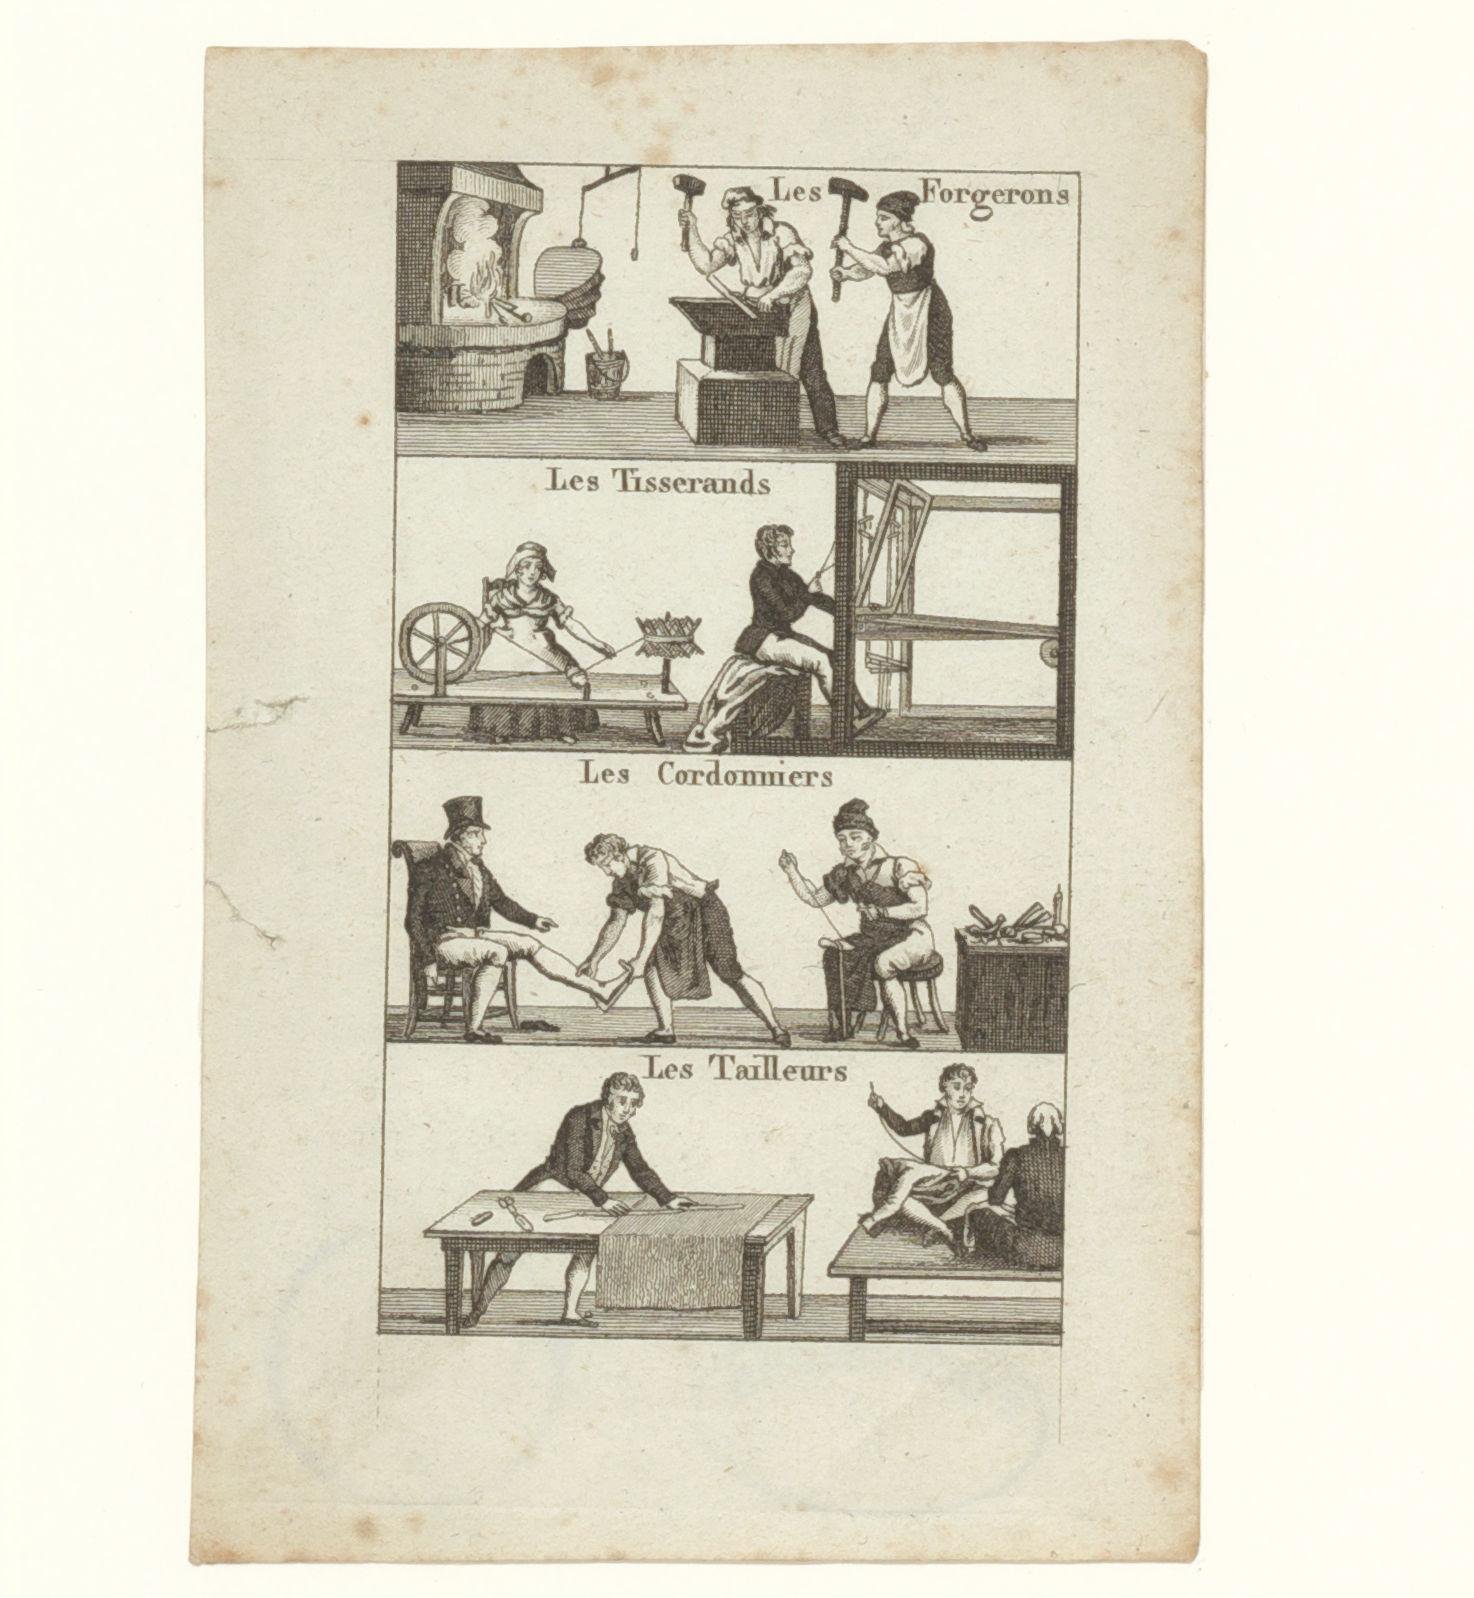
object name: print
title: Smeden / wevers / schoenmakers / kleermakers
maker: Anonymous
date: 1700-1799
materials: paper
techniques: engraving, etching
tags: craft-production, skilled handiwork, handicrafts, craftsman at work, smith, blacksmith, tailor, dressmaker, shoe-maker, cobbler, textile industry and clothing industry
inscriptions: stamp, collector's mark: Lugt 1641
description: Onderwerpsrubrieken binnen de Atlas Zeden en Gewoonten: Handel, Nijverheid en Verkeer, Beroep en bedrijf, Complete suites.